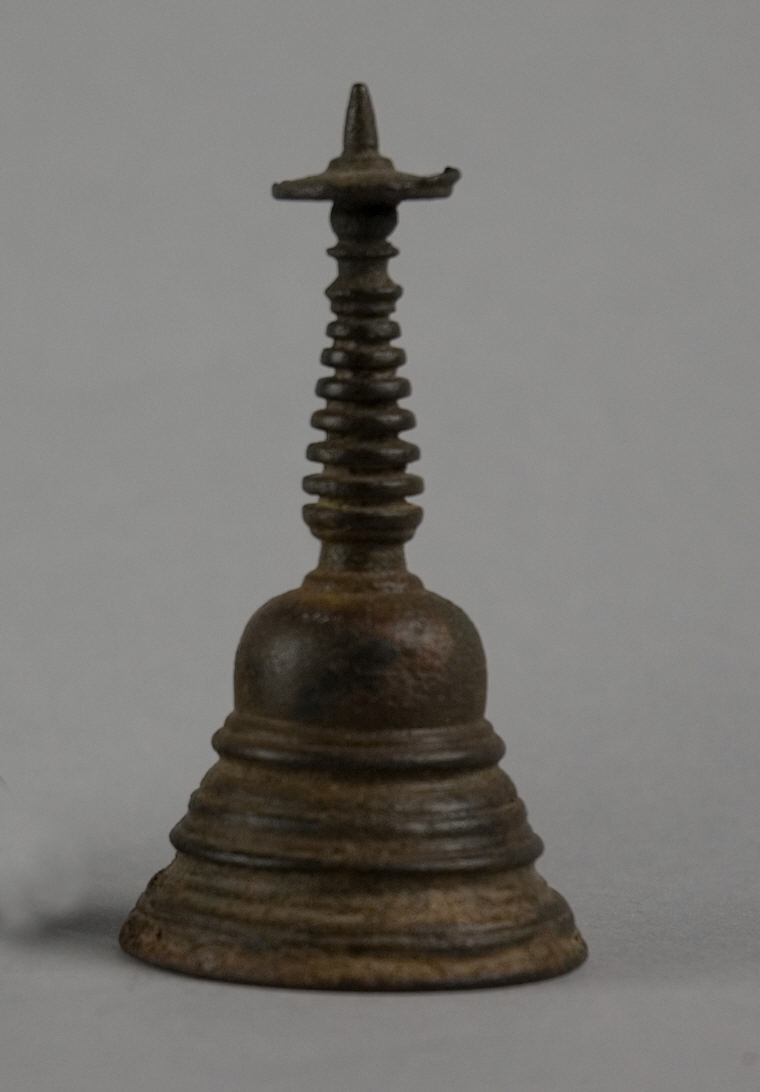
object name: stupa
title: Bell-Shaped Stupa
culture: burmese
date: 1101-1200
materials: bronze